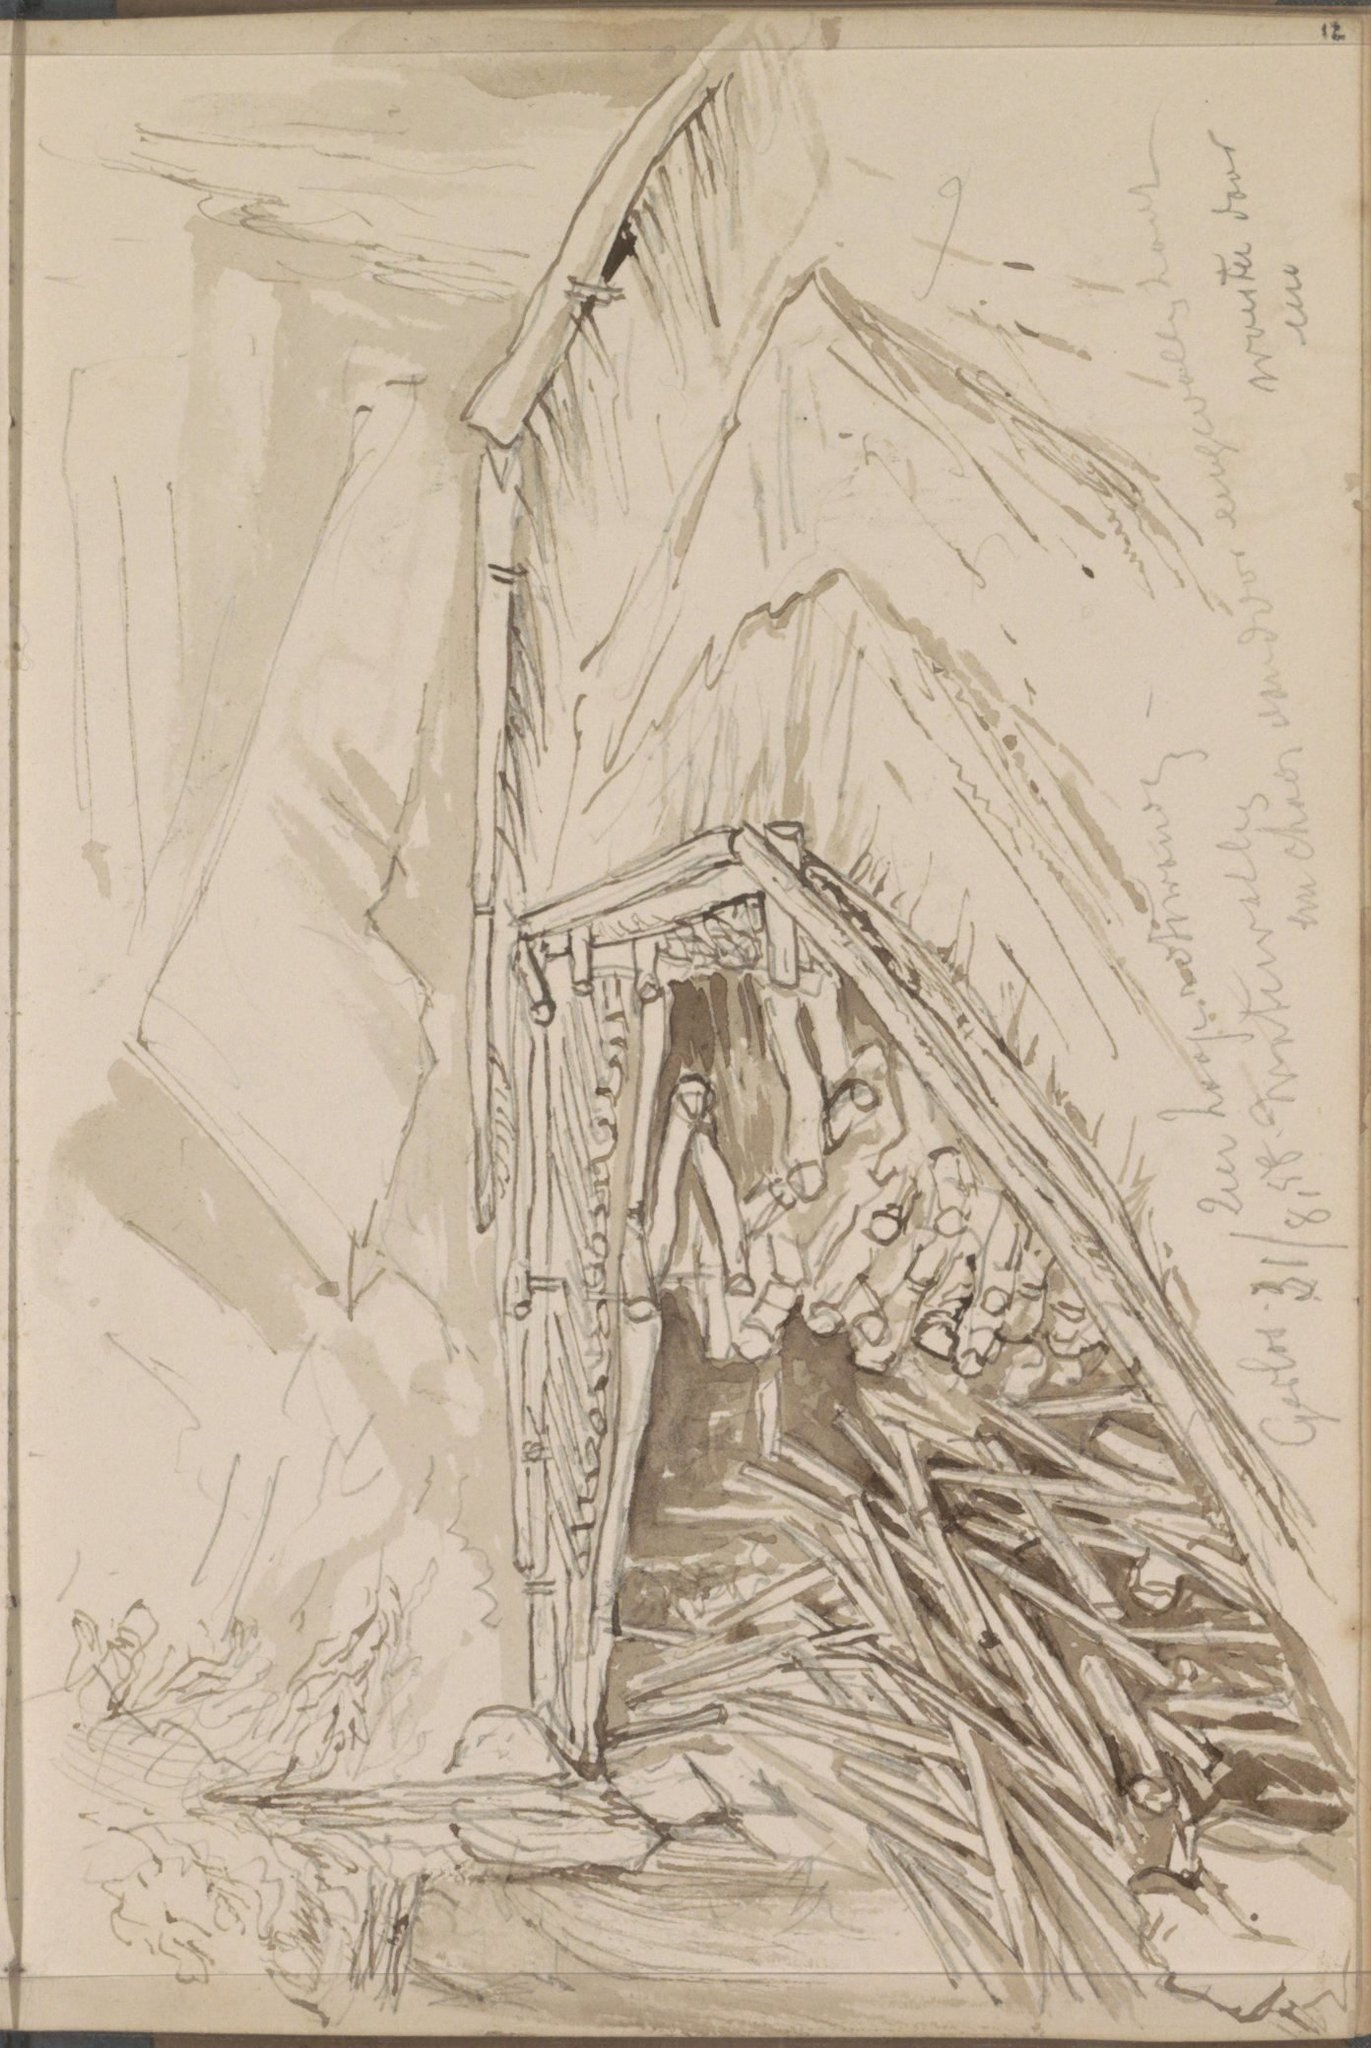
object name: sketchbook leaf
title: Berglandschap met een brug over een vallei waarin stapels boomstammen liggen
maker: johannes tavenraat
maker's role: draughtsman, painter, print maker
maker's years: 1809-1881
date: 1808-1858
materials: ink, paper, pencil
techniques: brush, pen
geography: gerlos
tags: dale, valley, wood, timber ~ building material, bridge, mountains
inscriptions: date and inscription: ‘Gerlos 31/8 58/ zeer hooge [...]/ watervally/ en chaos van door eengevallen hout/ woester door/ [...]’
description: Blad 12 recto uit een schetsboek met 47 bladen.